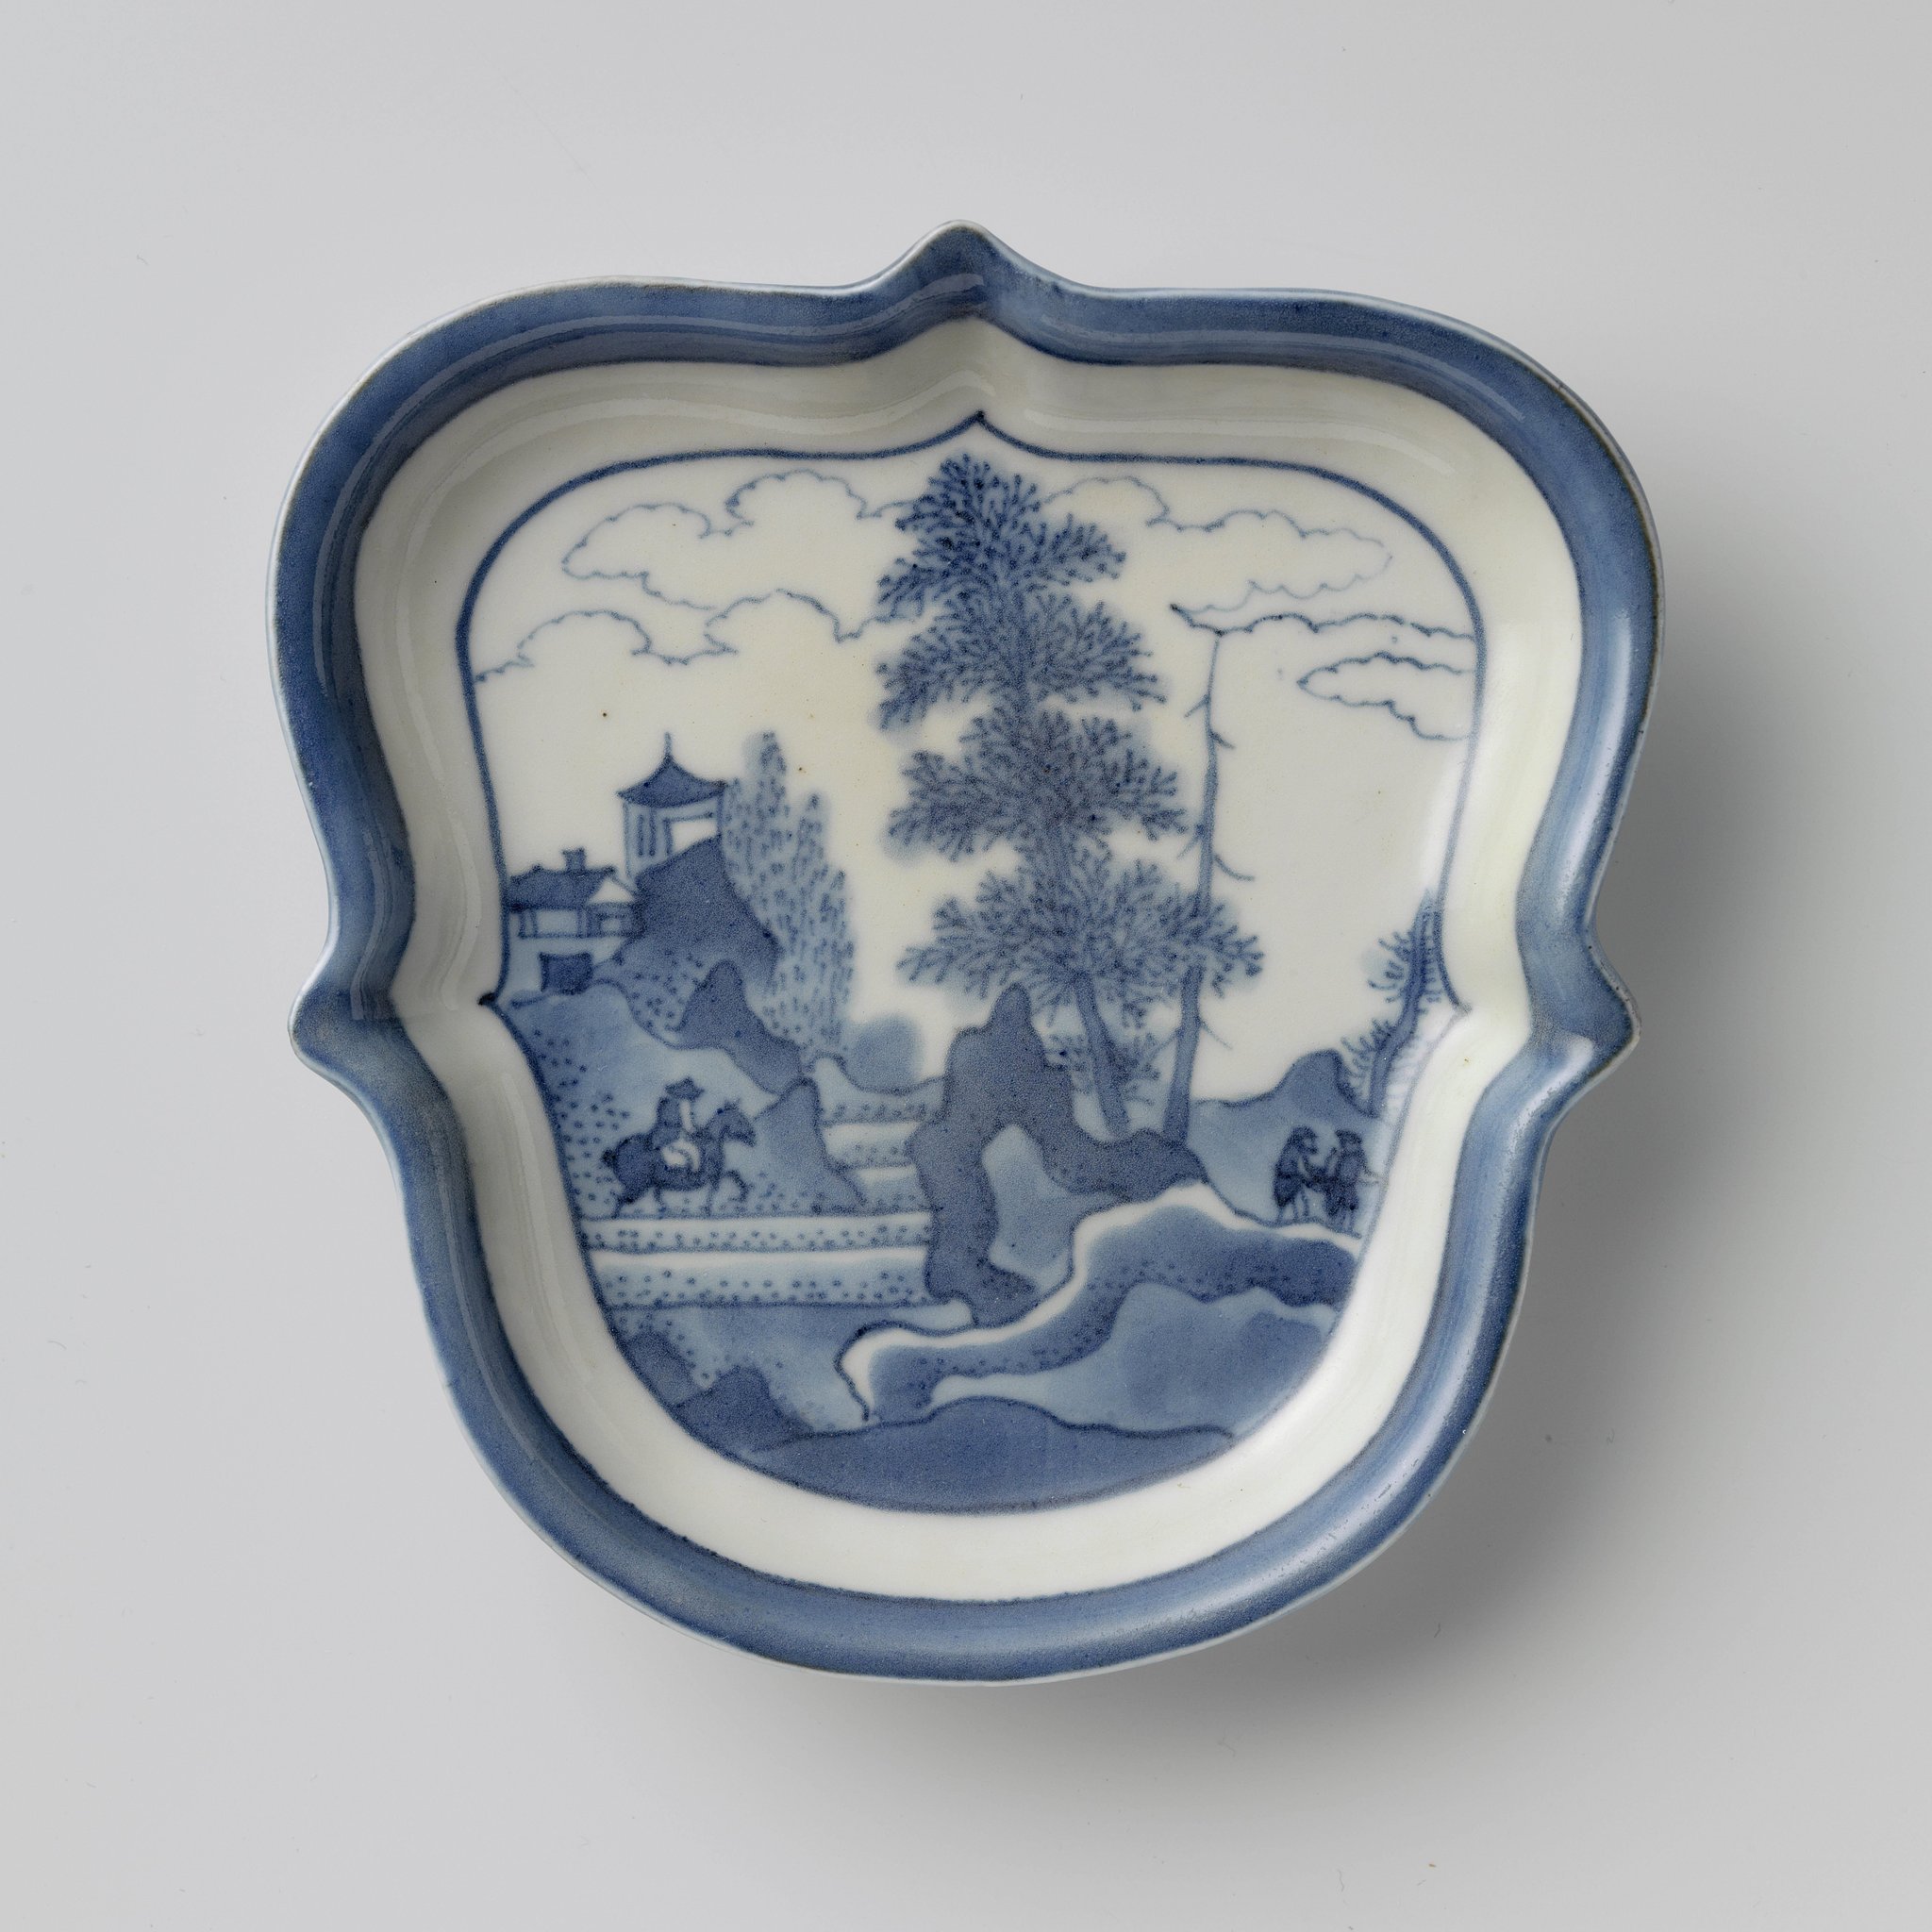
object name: dish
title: Saucer with figures in a landscape with trees, rocks and pavilions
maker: Anonymous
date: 1700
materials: cobalt, glaze, paint, porcelain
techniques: firing, forming, vitrification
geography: arita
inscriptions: mark: ‘大 明 成 化 年 製 dà míng Chénghuà nián zhì’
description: Schaal van porselein met accoladevormige wand en rand, beschilderd in onderglazuur blauw. Op het plat een landschap met daarin een ruiter en twee lopende mensen tussen rotsen en bomen. Op de achtergrond twee paviljoens en wolken. De binnenrand is met een blauwe band. Gemerkt op de onderzijde met het zes-karaktermerk van keizer Chenghua. Twee proenen op de onderzijde. Arita, blauw-wit.